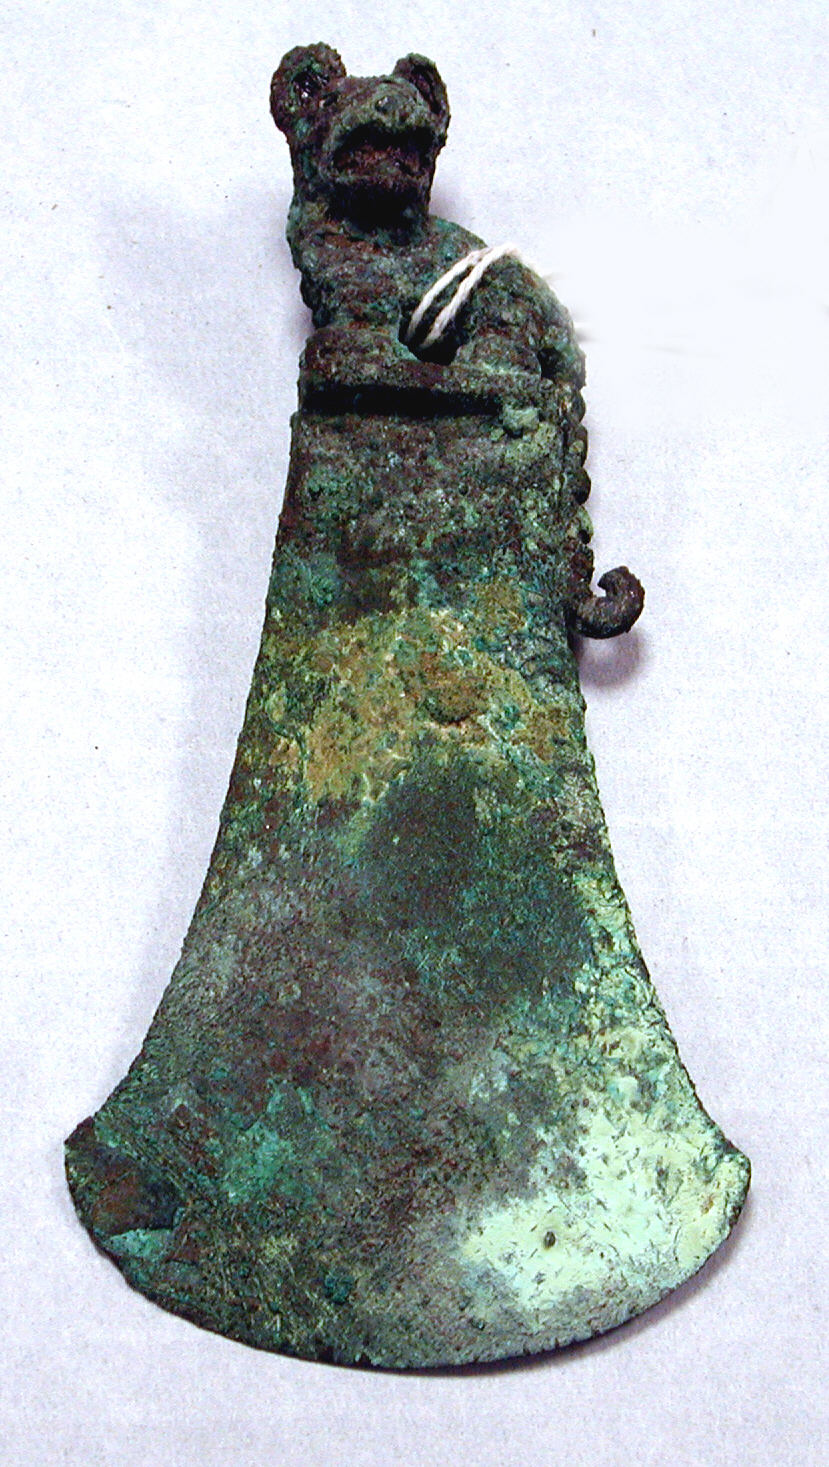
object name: knife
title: Knife, Feline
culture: moche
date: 101-700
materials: copper, shell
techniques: casting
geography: peru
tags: cats